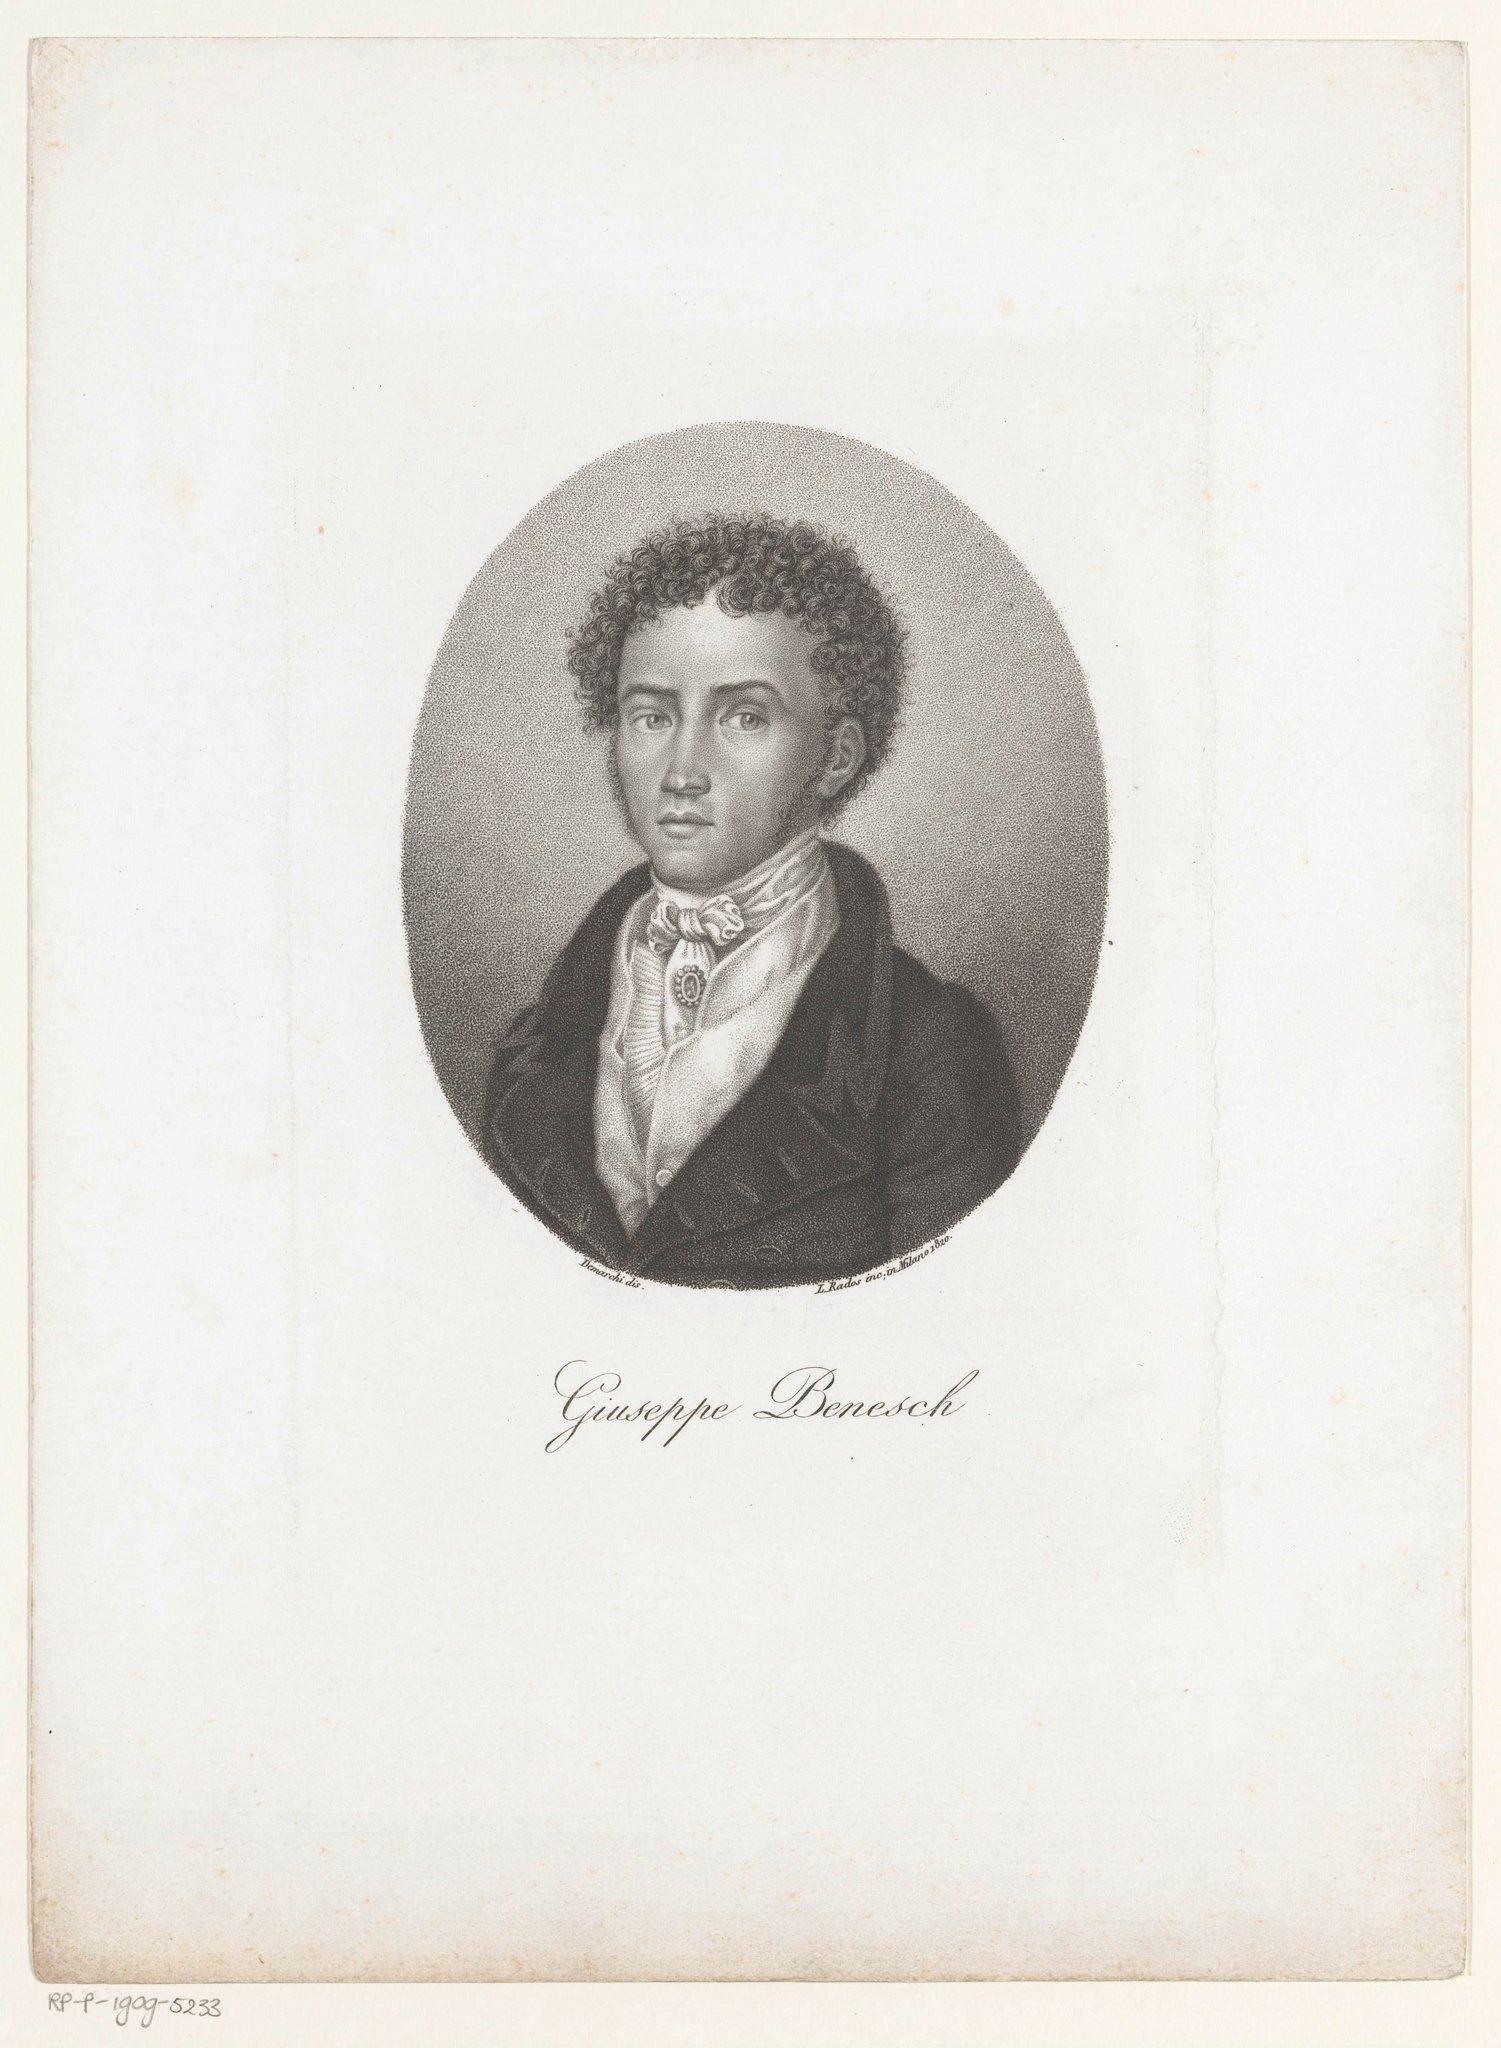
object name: print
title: Portret van Giuseppe Benesch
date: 1820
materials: paper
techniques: stippling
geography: milan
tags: historical persons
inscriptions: collector's mark: Lugt 2228